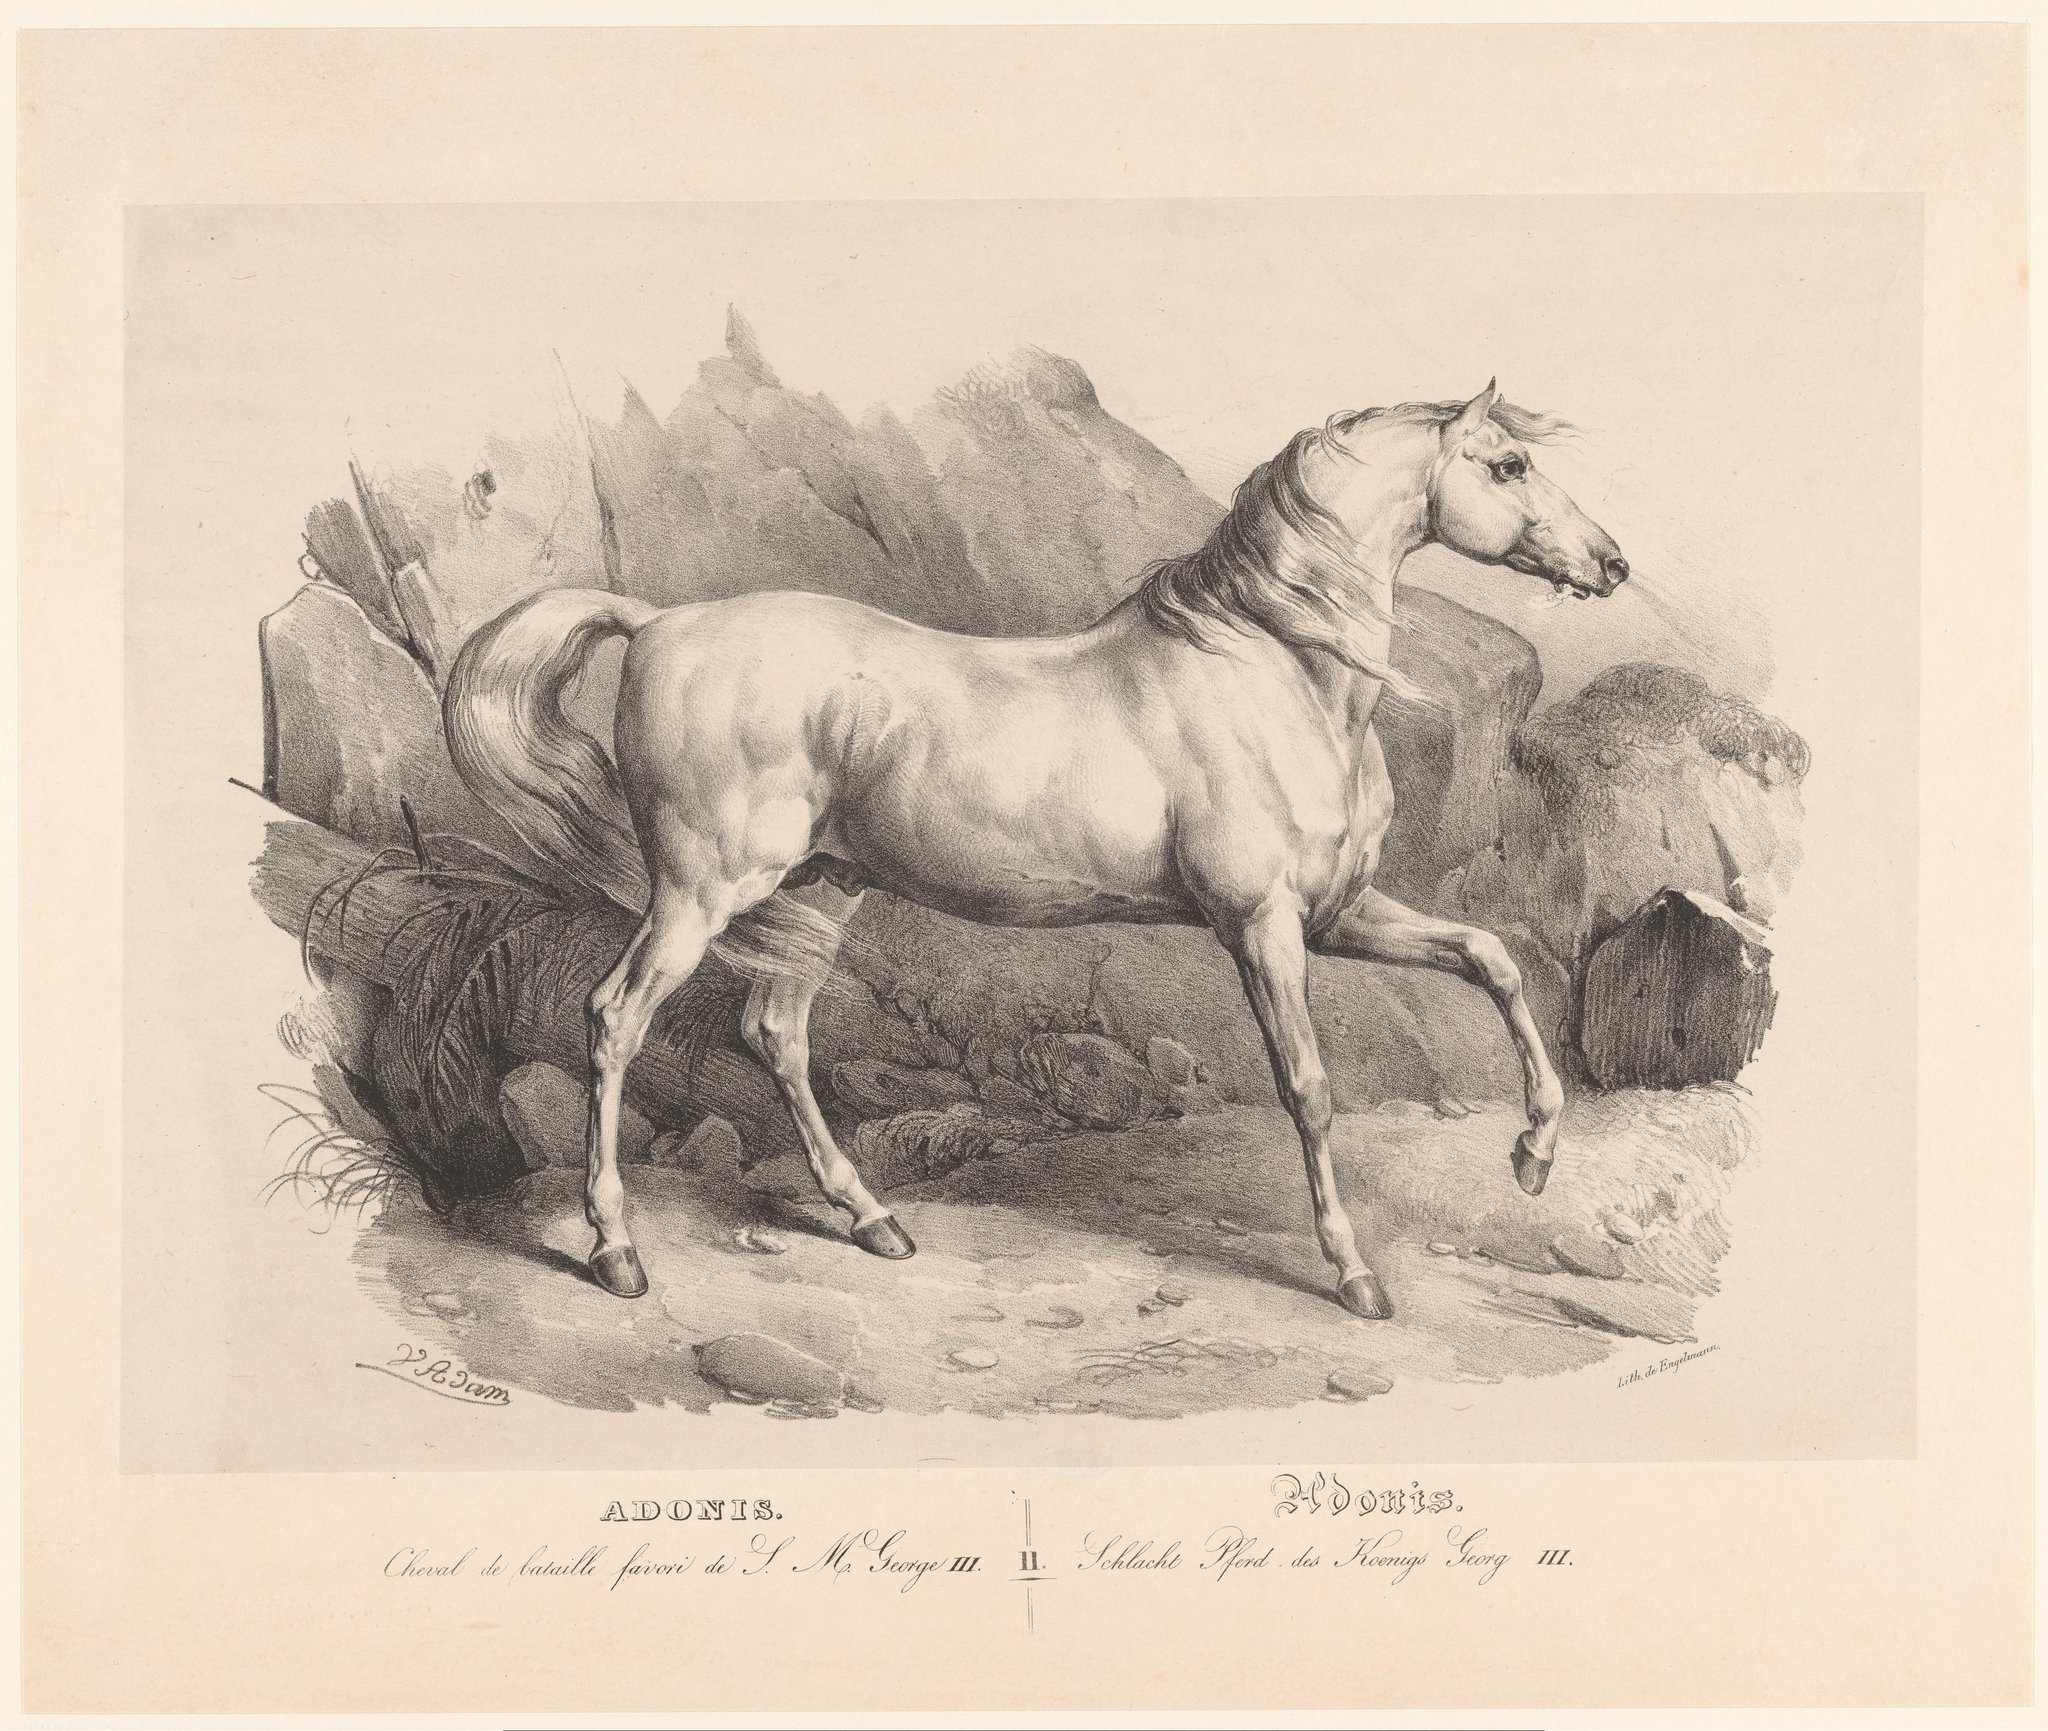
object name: print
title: Beroemde Engelse paarden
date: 1825-1827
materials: paper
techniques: lithograph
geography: paris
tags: horse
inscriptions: collector's mark: Lugt 2228